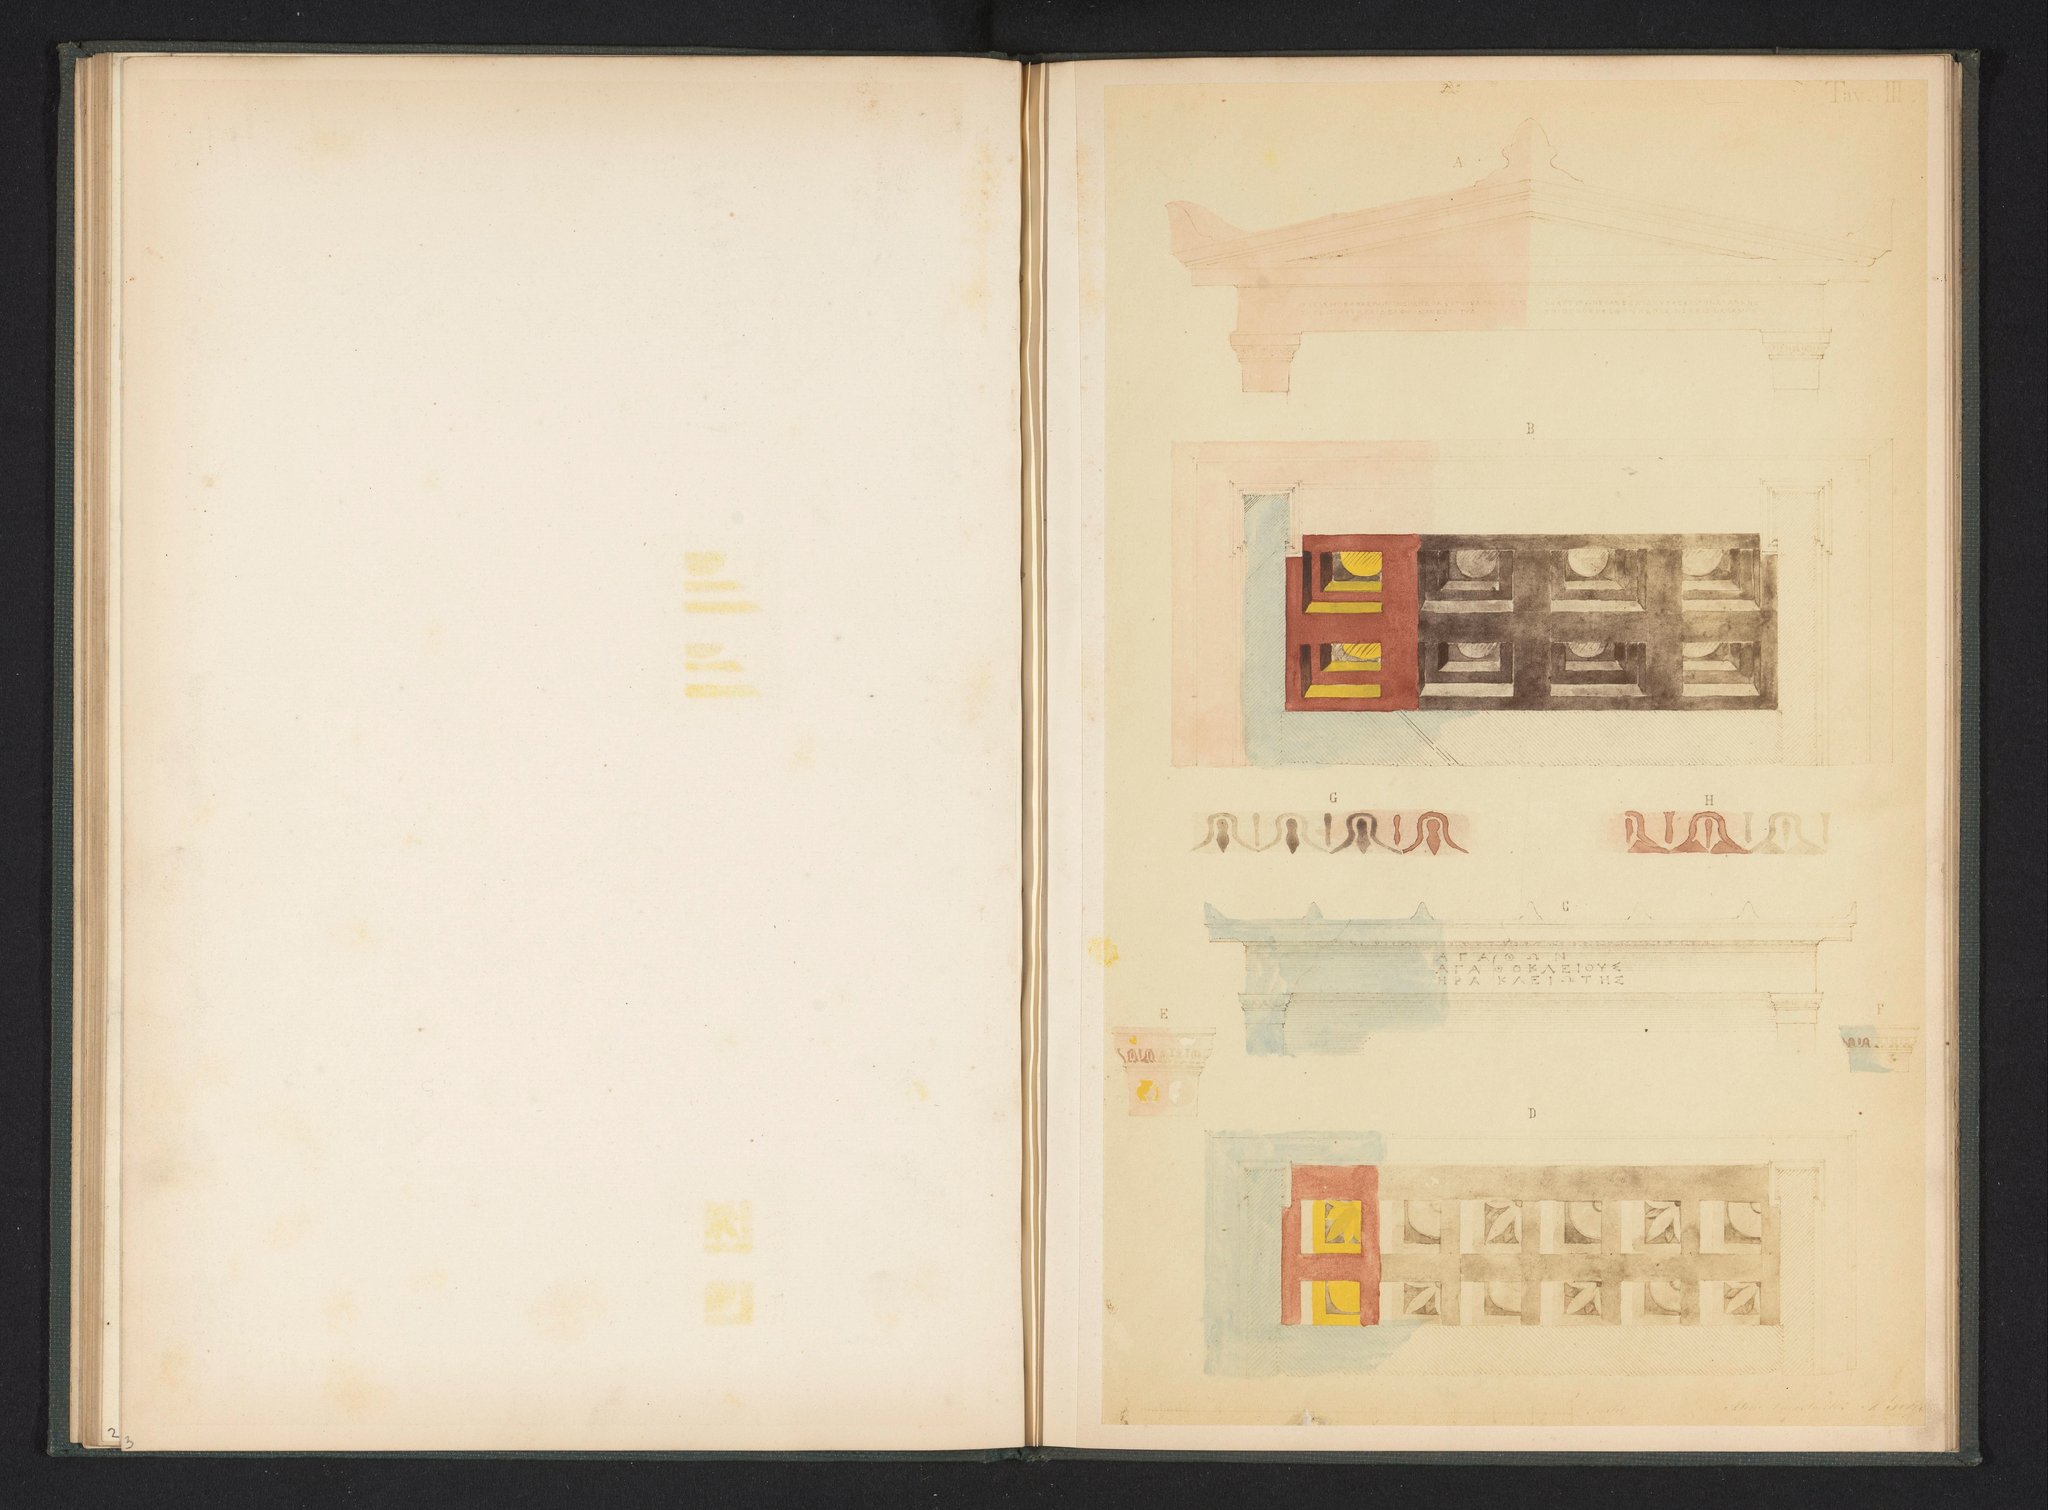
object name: reproduction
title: Fotoreproductie van tekeningen van timpanen en vermoedelijk cassette plafonds van een kerk in Athene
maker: Anonymous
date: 1863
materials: photographic support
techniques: albumen print, hand coloring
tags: parts of church exterior and annexes: tympanum, (decorated) ceiling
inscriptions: number: ‘Tav. III.’